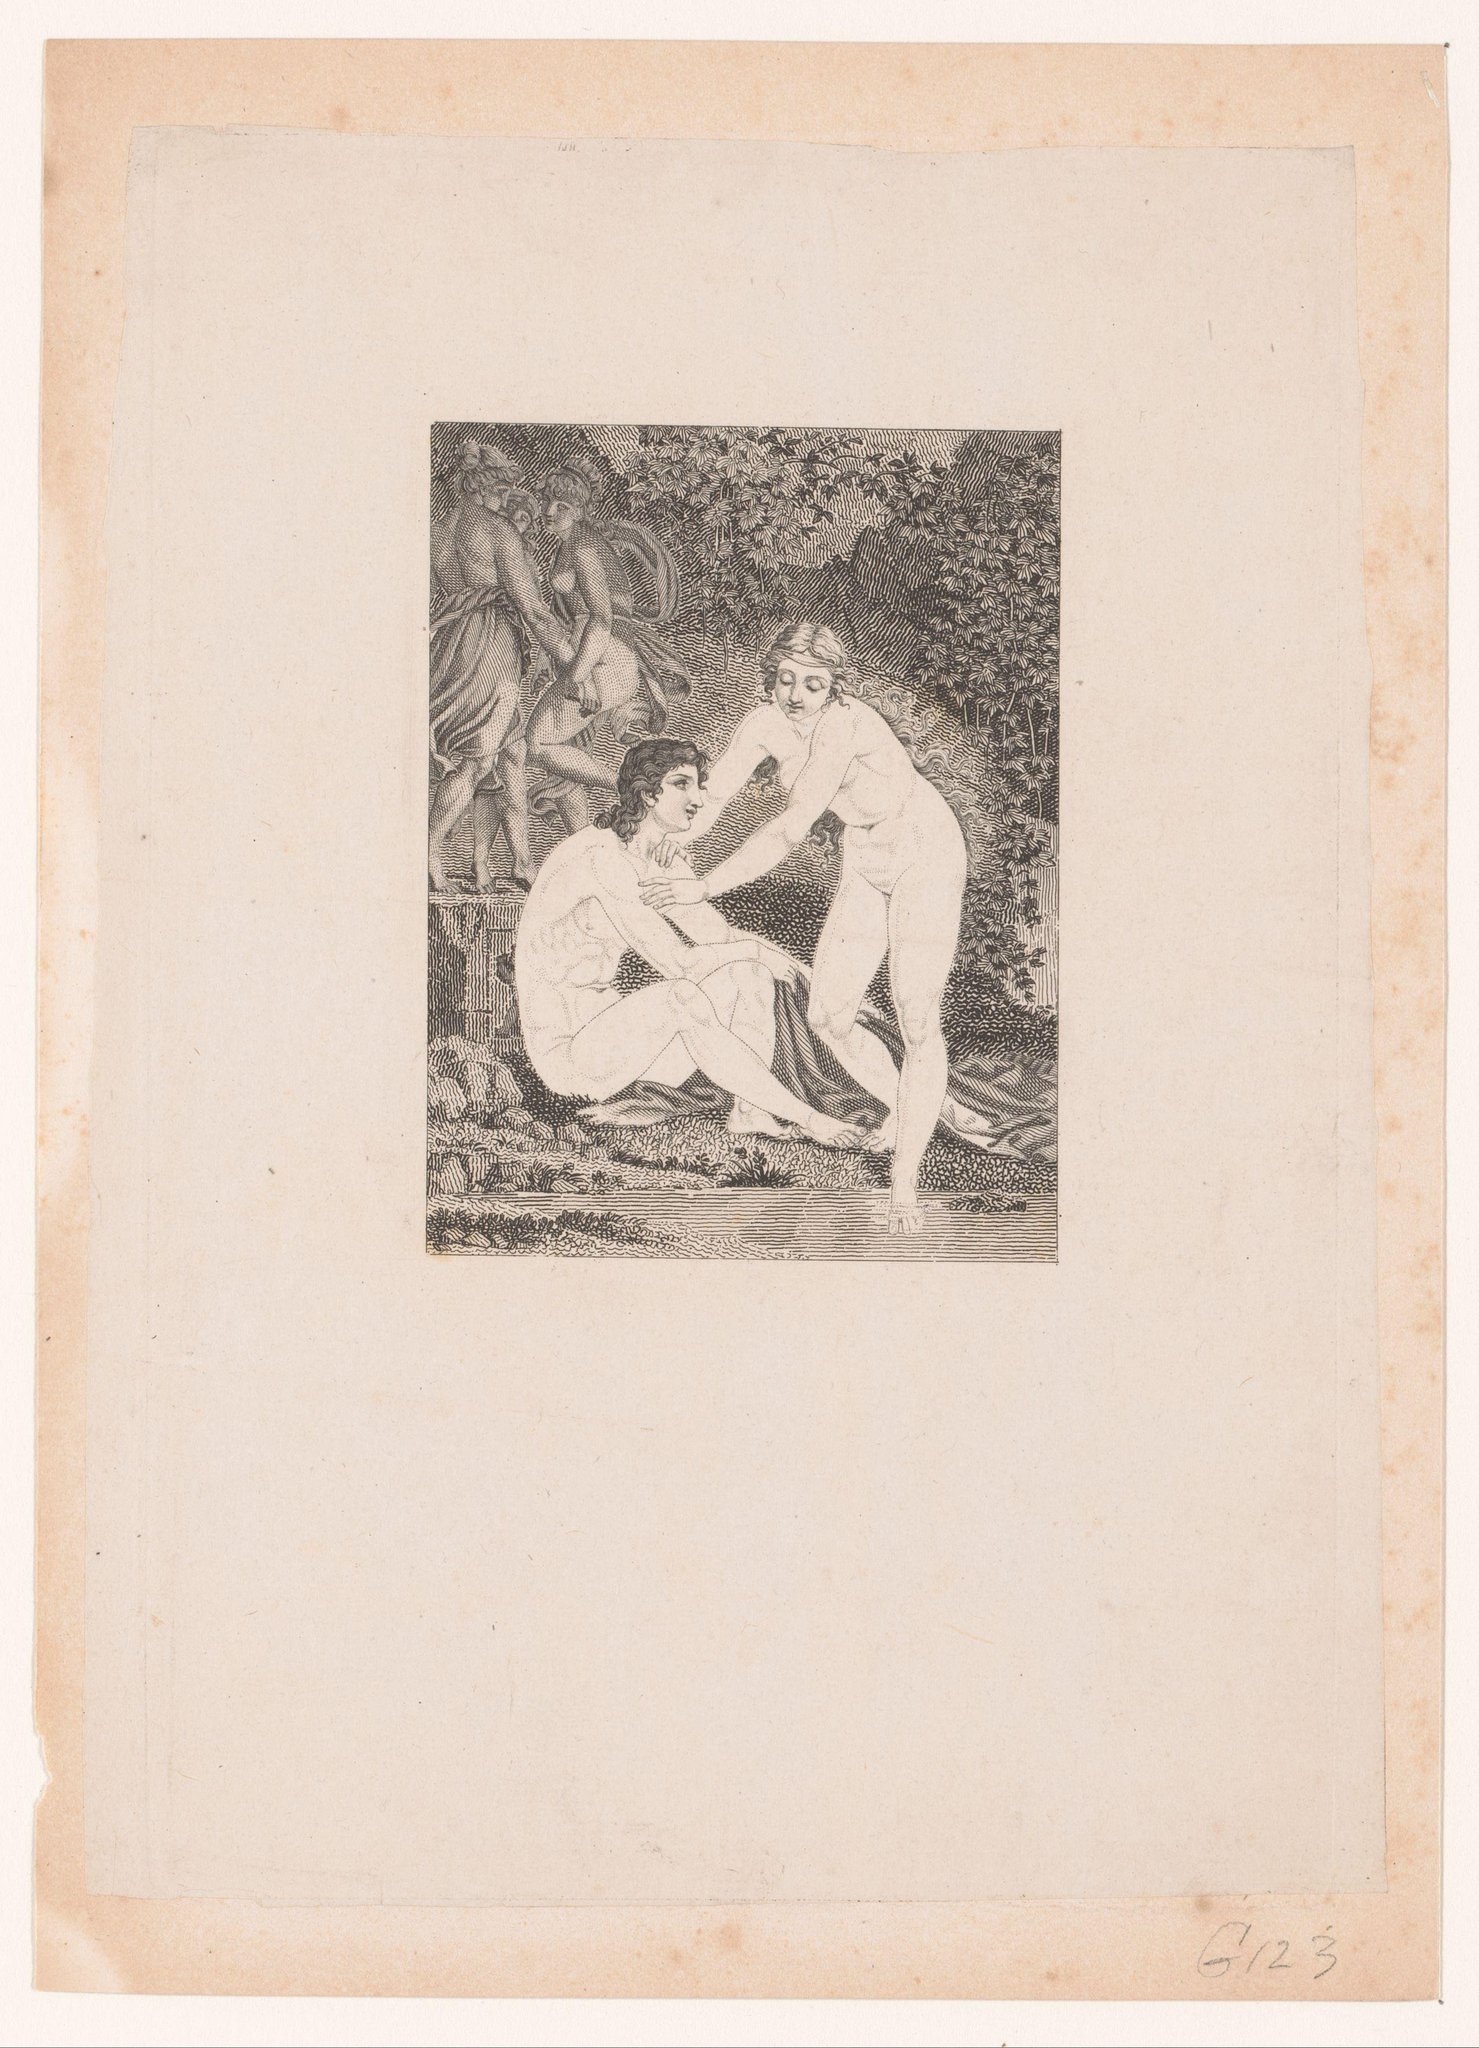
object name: print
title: Daphnis en Chloë badend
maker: hyacinthe louis victor jean baptiste aubry-lecomte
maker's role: print maker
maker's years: 1787-1858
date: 1807-1858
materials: paper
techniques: etching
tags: daphnis (in greek mythology a shepherd who invented pastoral poetry, chloe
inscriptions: collector's mark: Lugt 2228